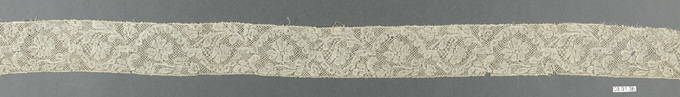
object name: border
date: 1701-1733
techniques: lace